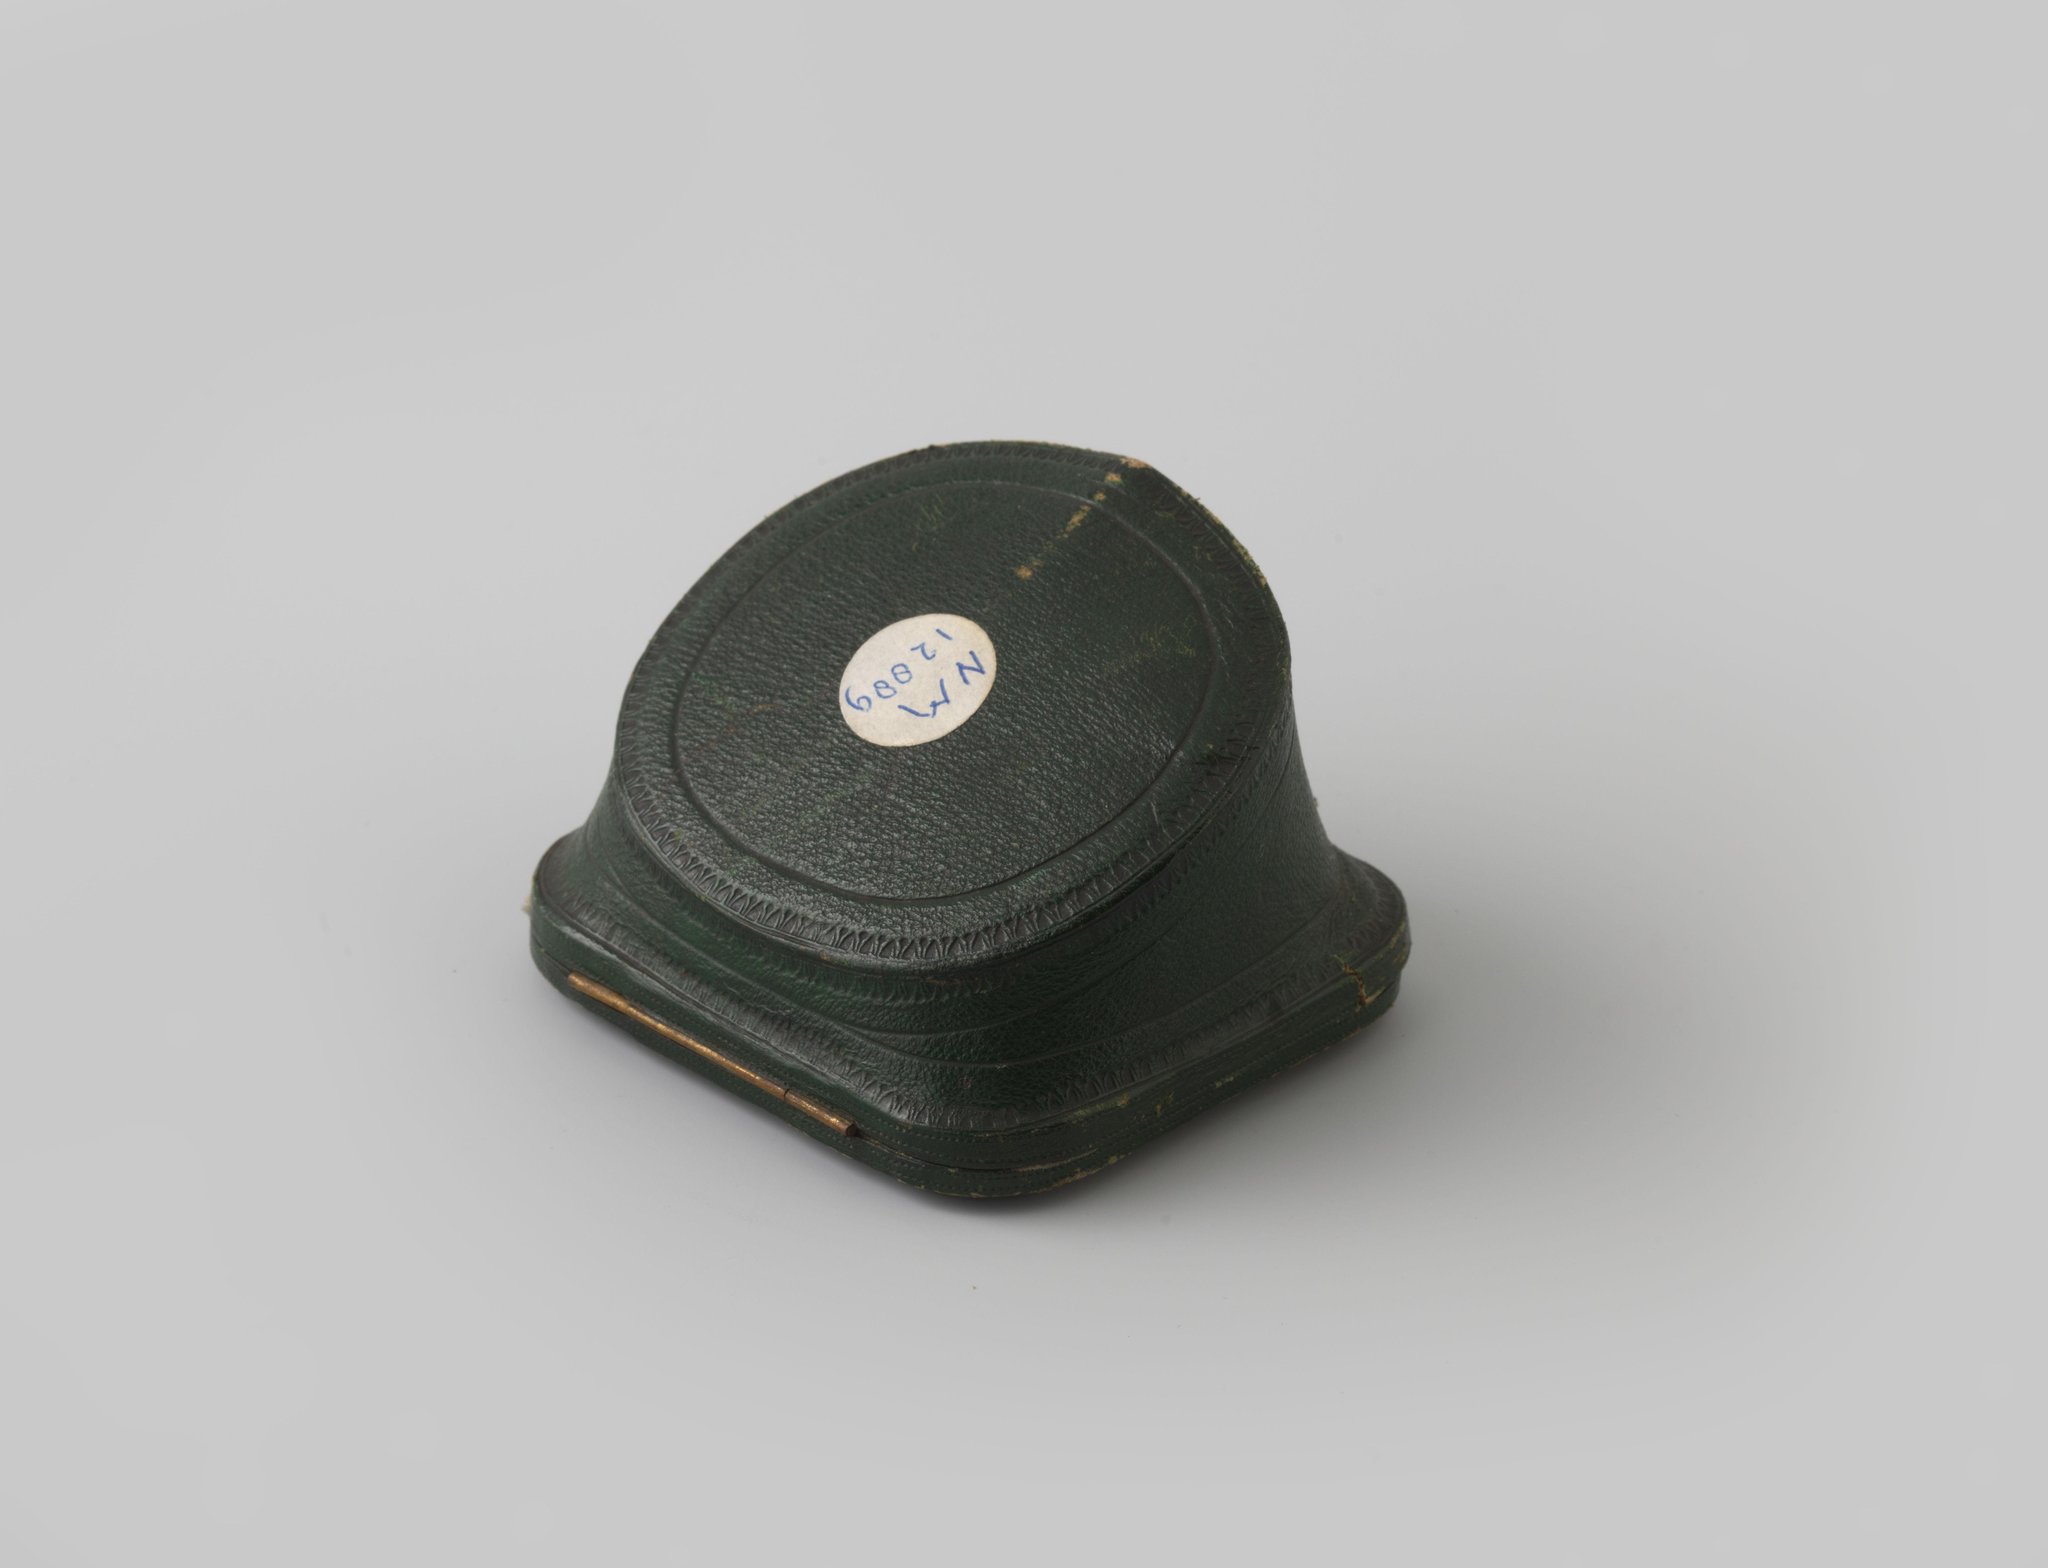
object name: étui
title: Groen foedraal voor armband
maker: Anonymous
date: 1845-1850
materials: leather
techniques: gilding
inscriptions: alloy mark: ‘leeuwenkop naar links (1813-1906)’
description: Groen foedraal voor armband met schuinaflopend deksel.